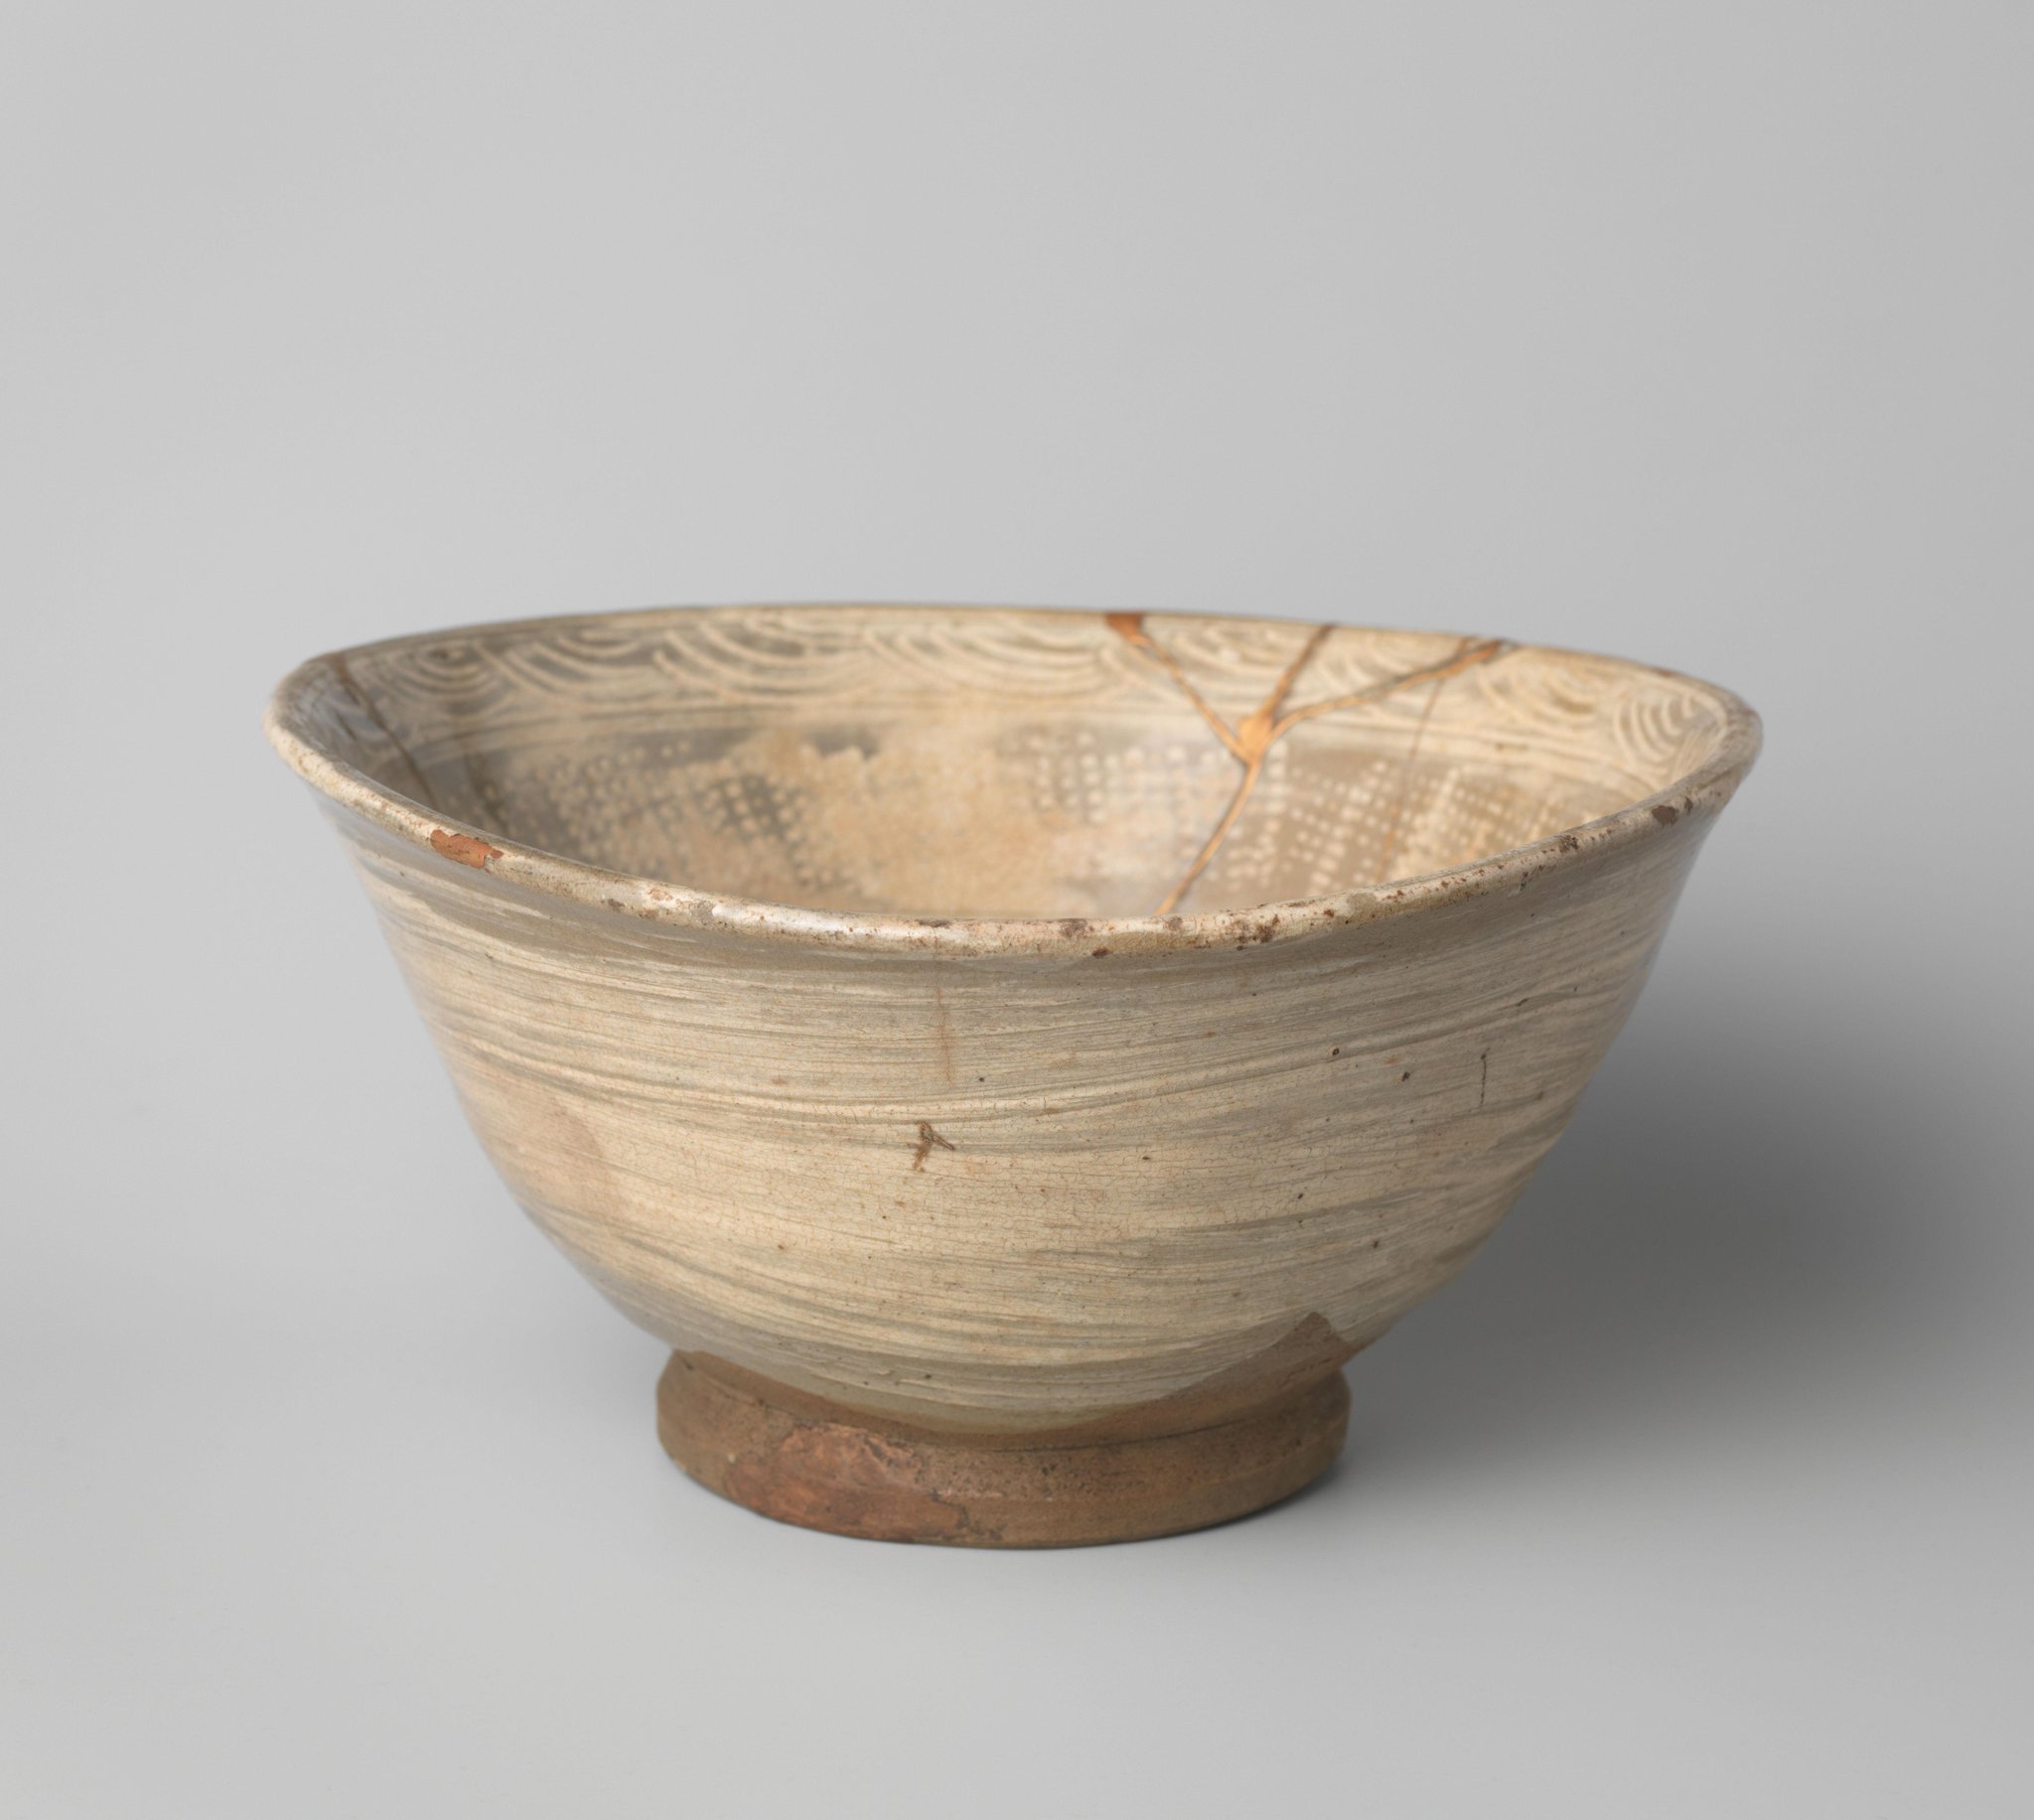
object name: bowl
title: Bowl with incised floral patterns and ornamental borders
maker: Anonymous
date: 1700-1799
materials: glaze, stoneware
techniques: engraving, firing, turning, vitrification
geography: korea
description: The inside of this bowl was decorated with stamped and carved motifs, which were then filled with white slip. A layer of white slip was brushed over the outer surface of the bowl. This type of stoneware was produced in large quantities and was an affordable imitation of the more precious white porcelain. The appearance was less smooth and refined, but more natural.